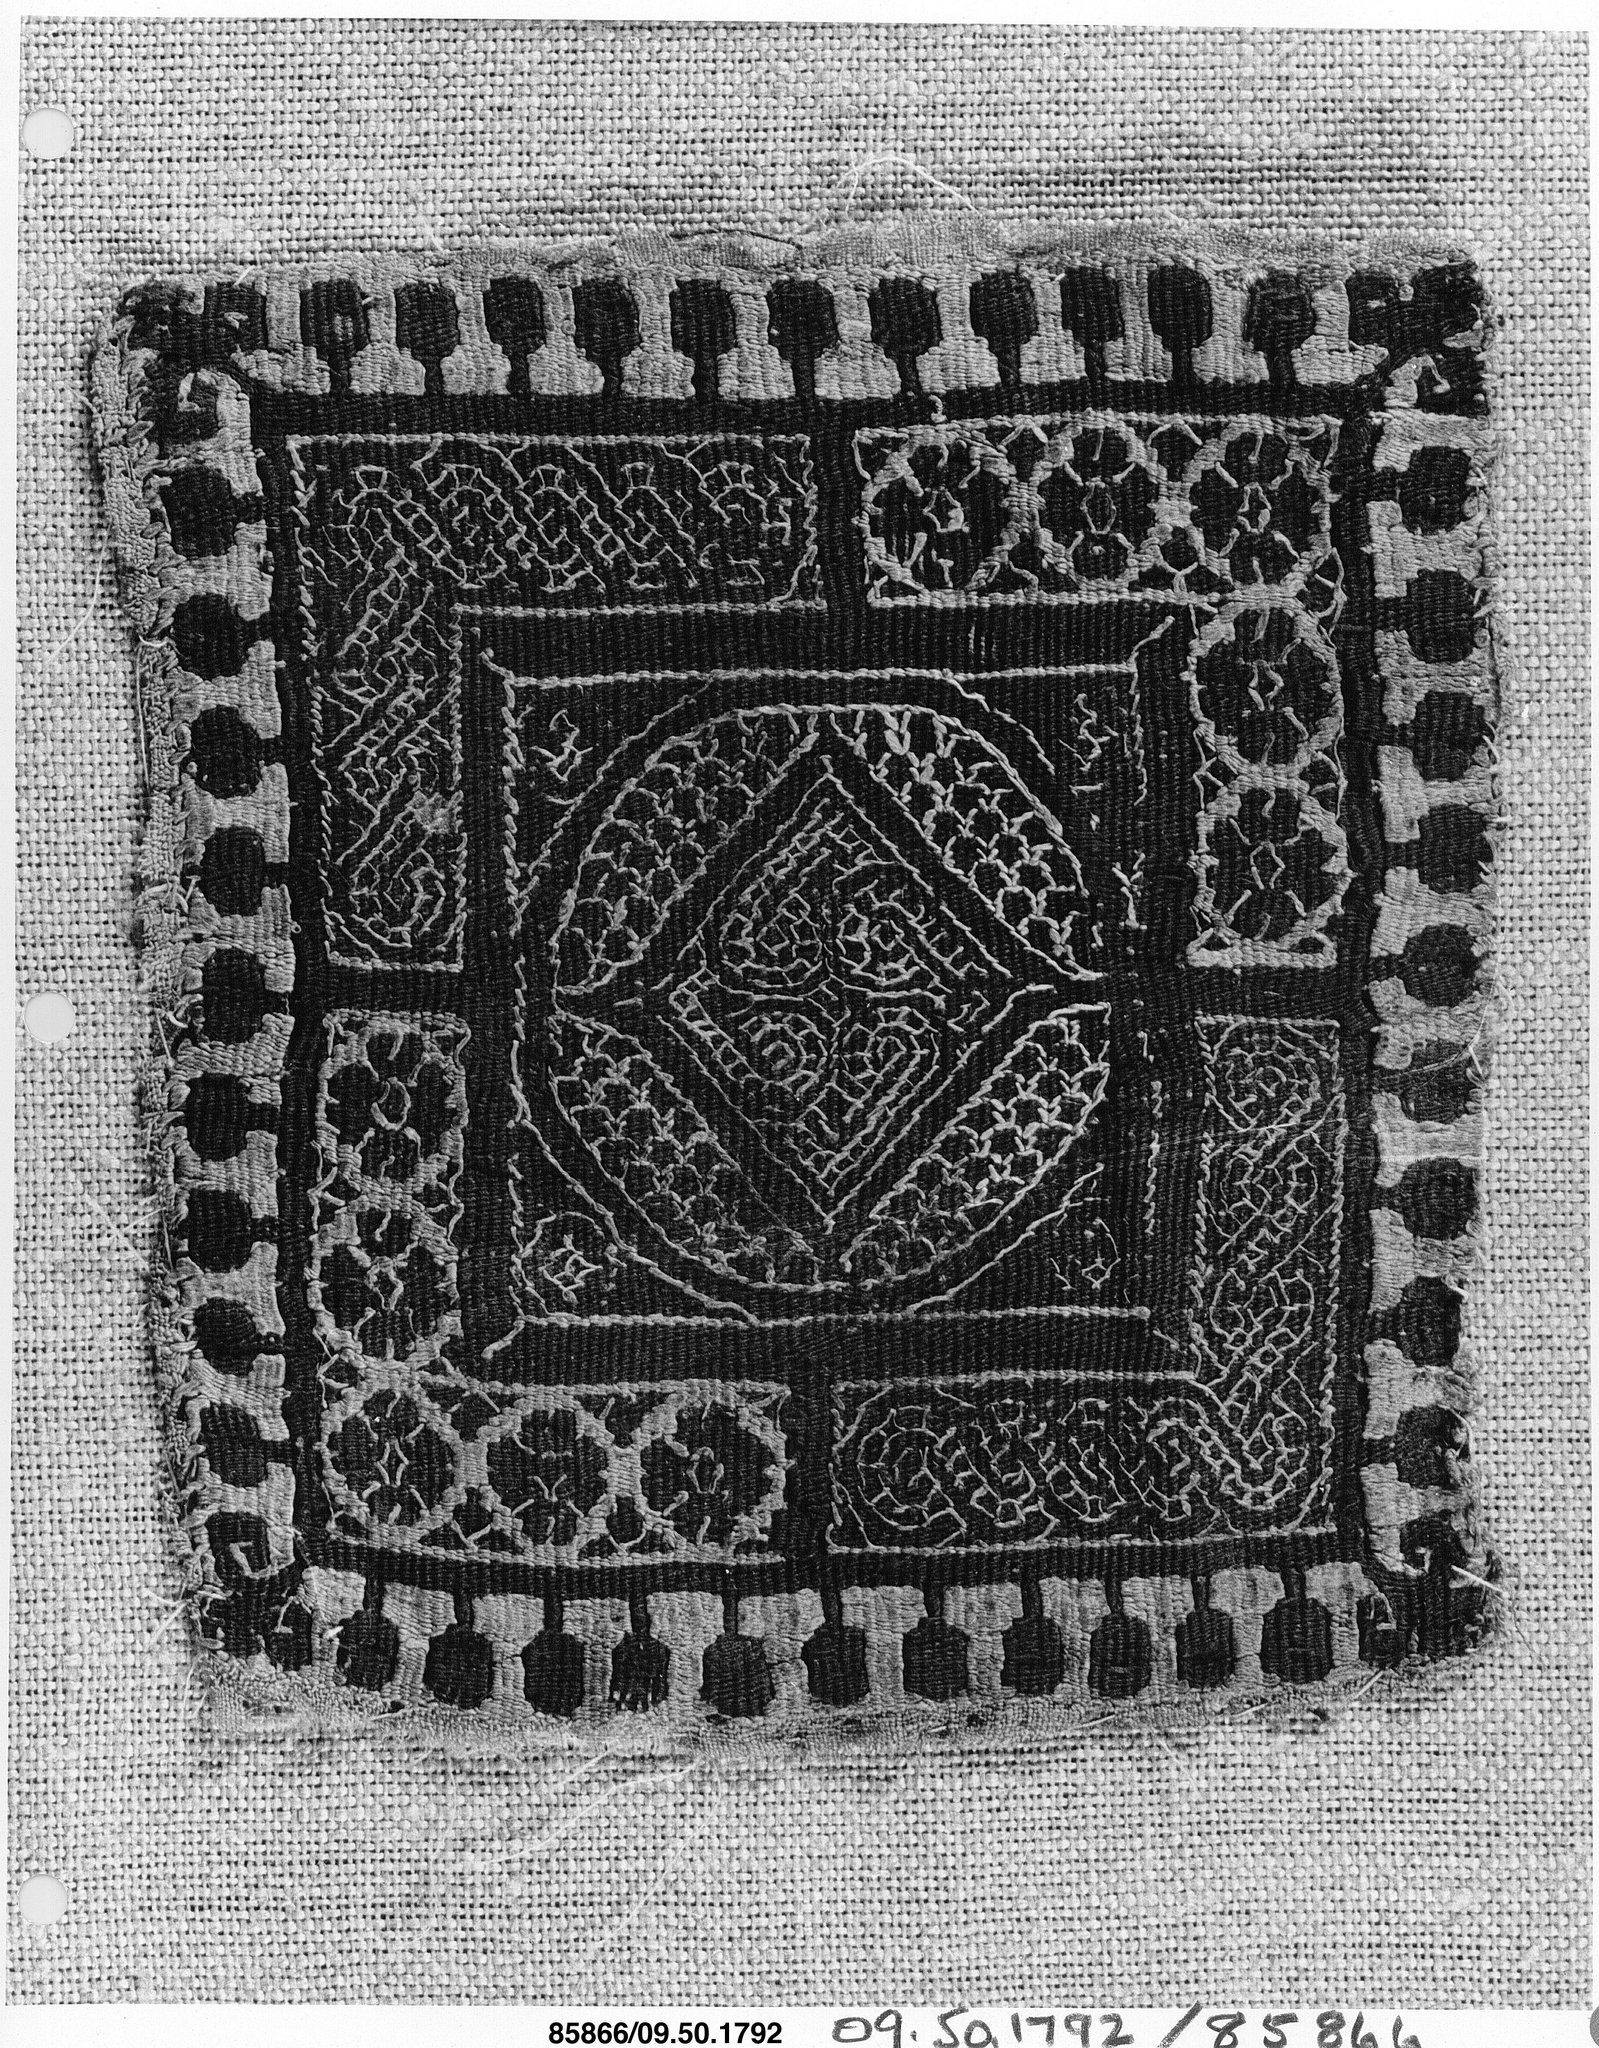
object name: square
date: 301-500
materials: linen, wool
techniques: weave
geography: egypt